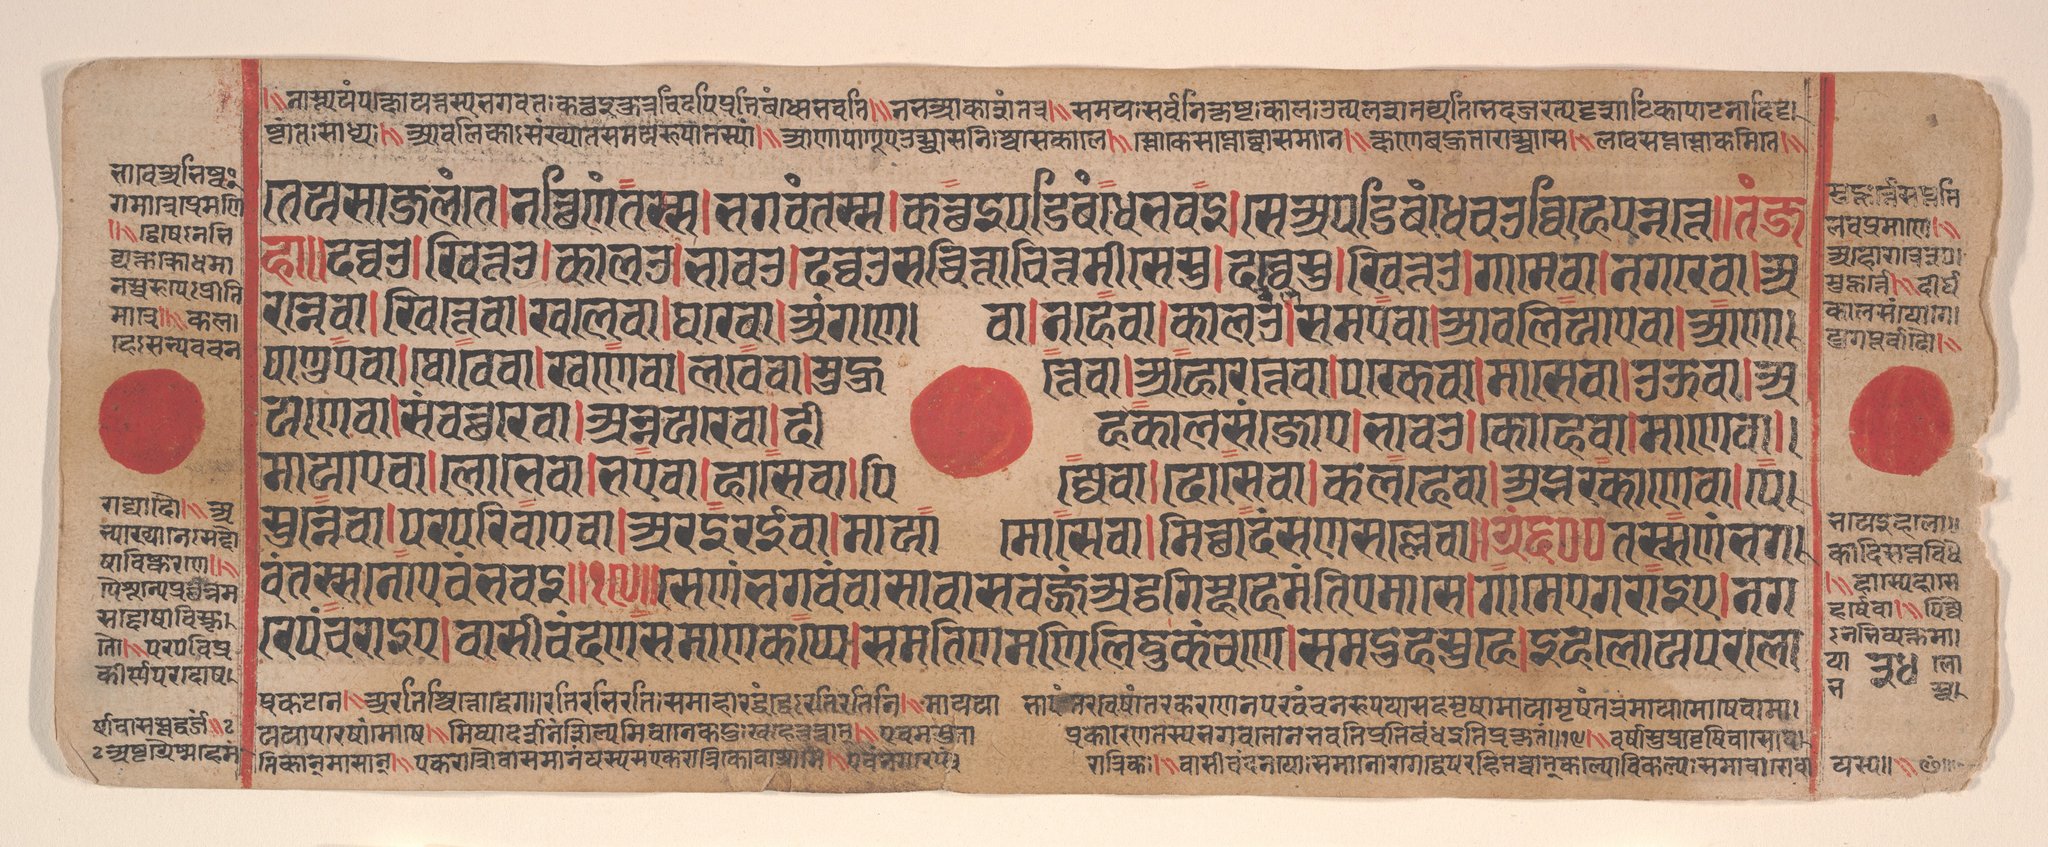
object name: folio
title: Leaf from a Kalpa Sutra (Jain Book of Rituals)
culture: indian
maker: bhadrabahu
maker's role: artist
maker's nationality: indian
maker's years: 356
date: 1401-1500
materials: gold, ink, paper, watercolor